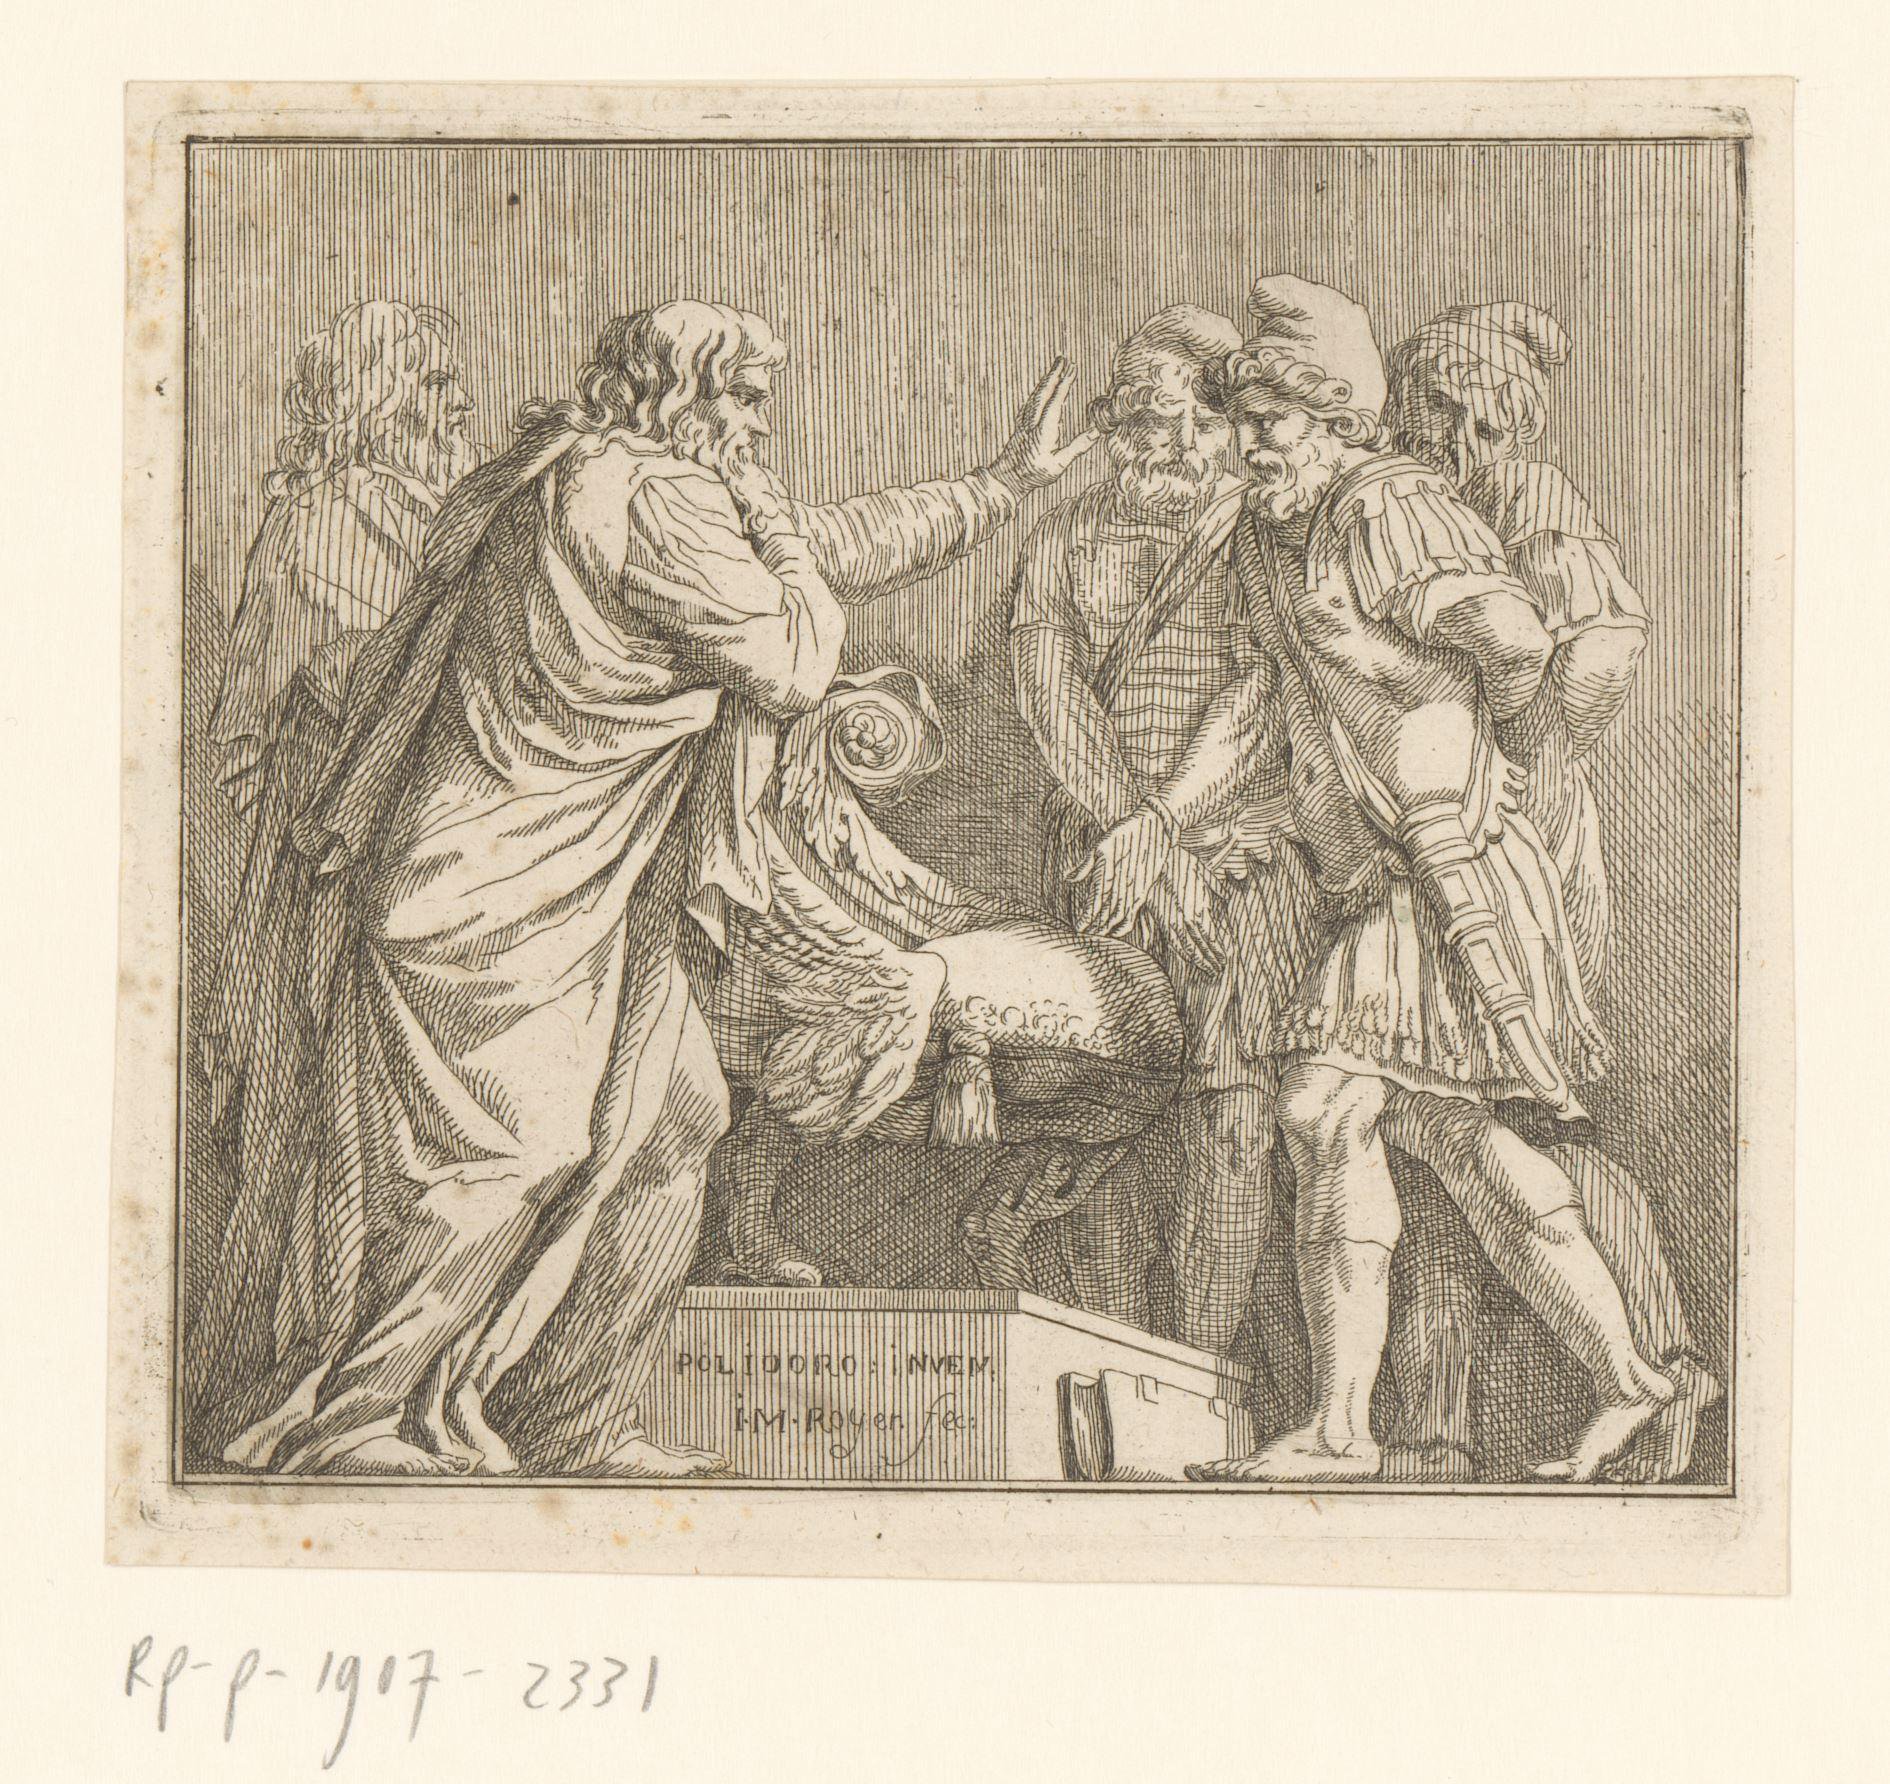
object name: print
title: Mythologisch-historische scene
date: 1765-1799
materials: paper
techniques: etching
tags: classical mythology and ancient history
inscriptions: collector's mark: Lugt 2228